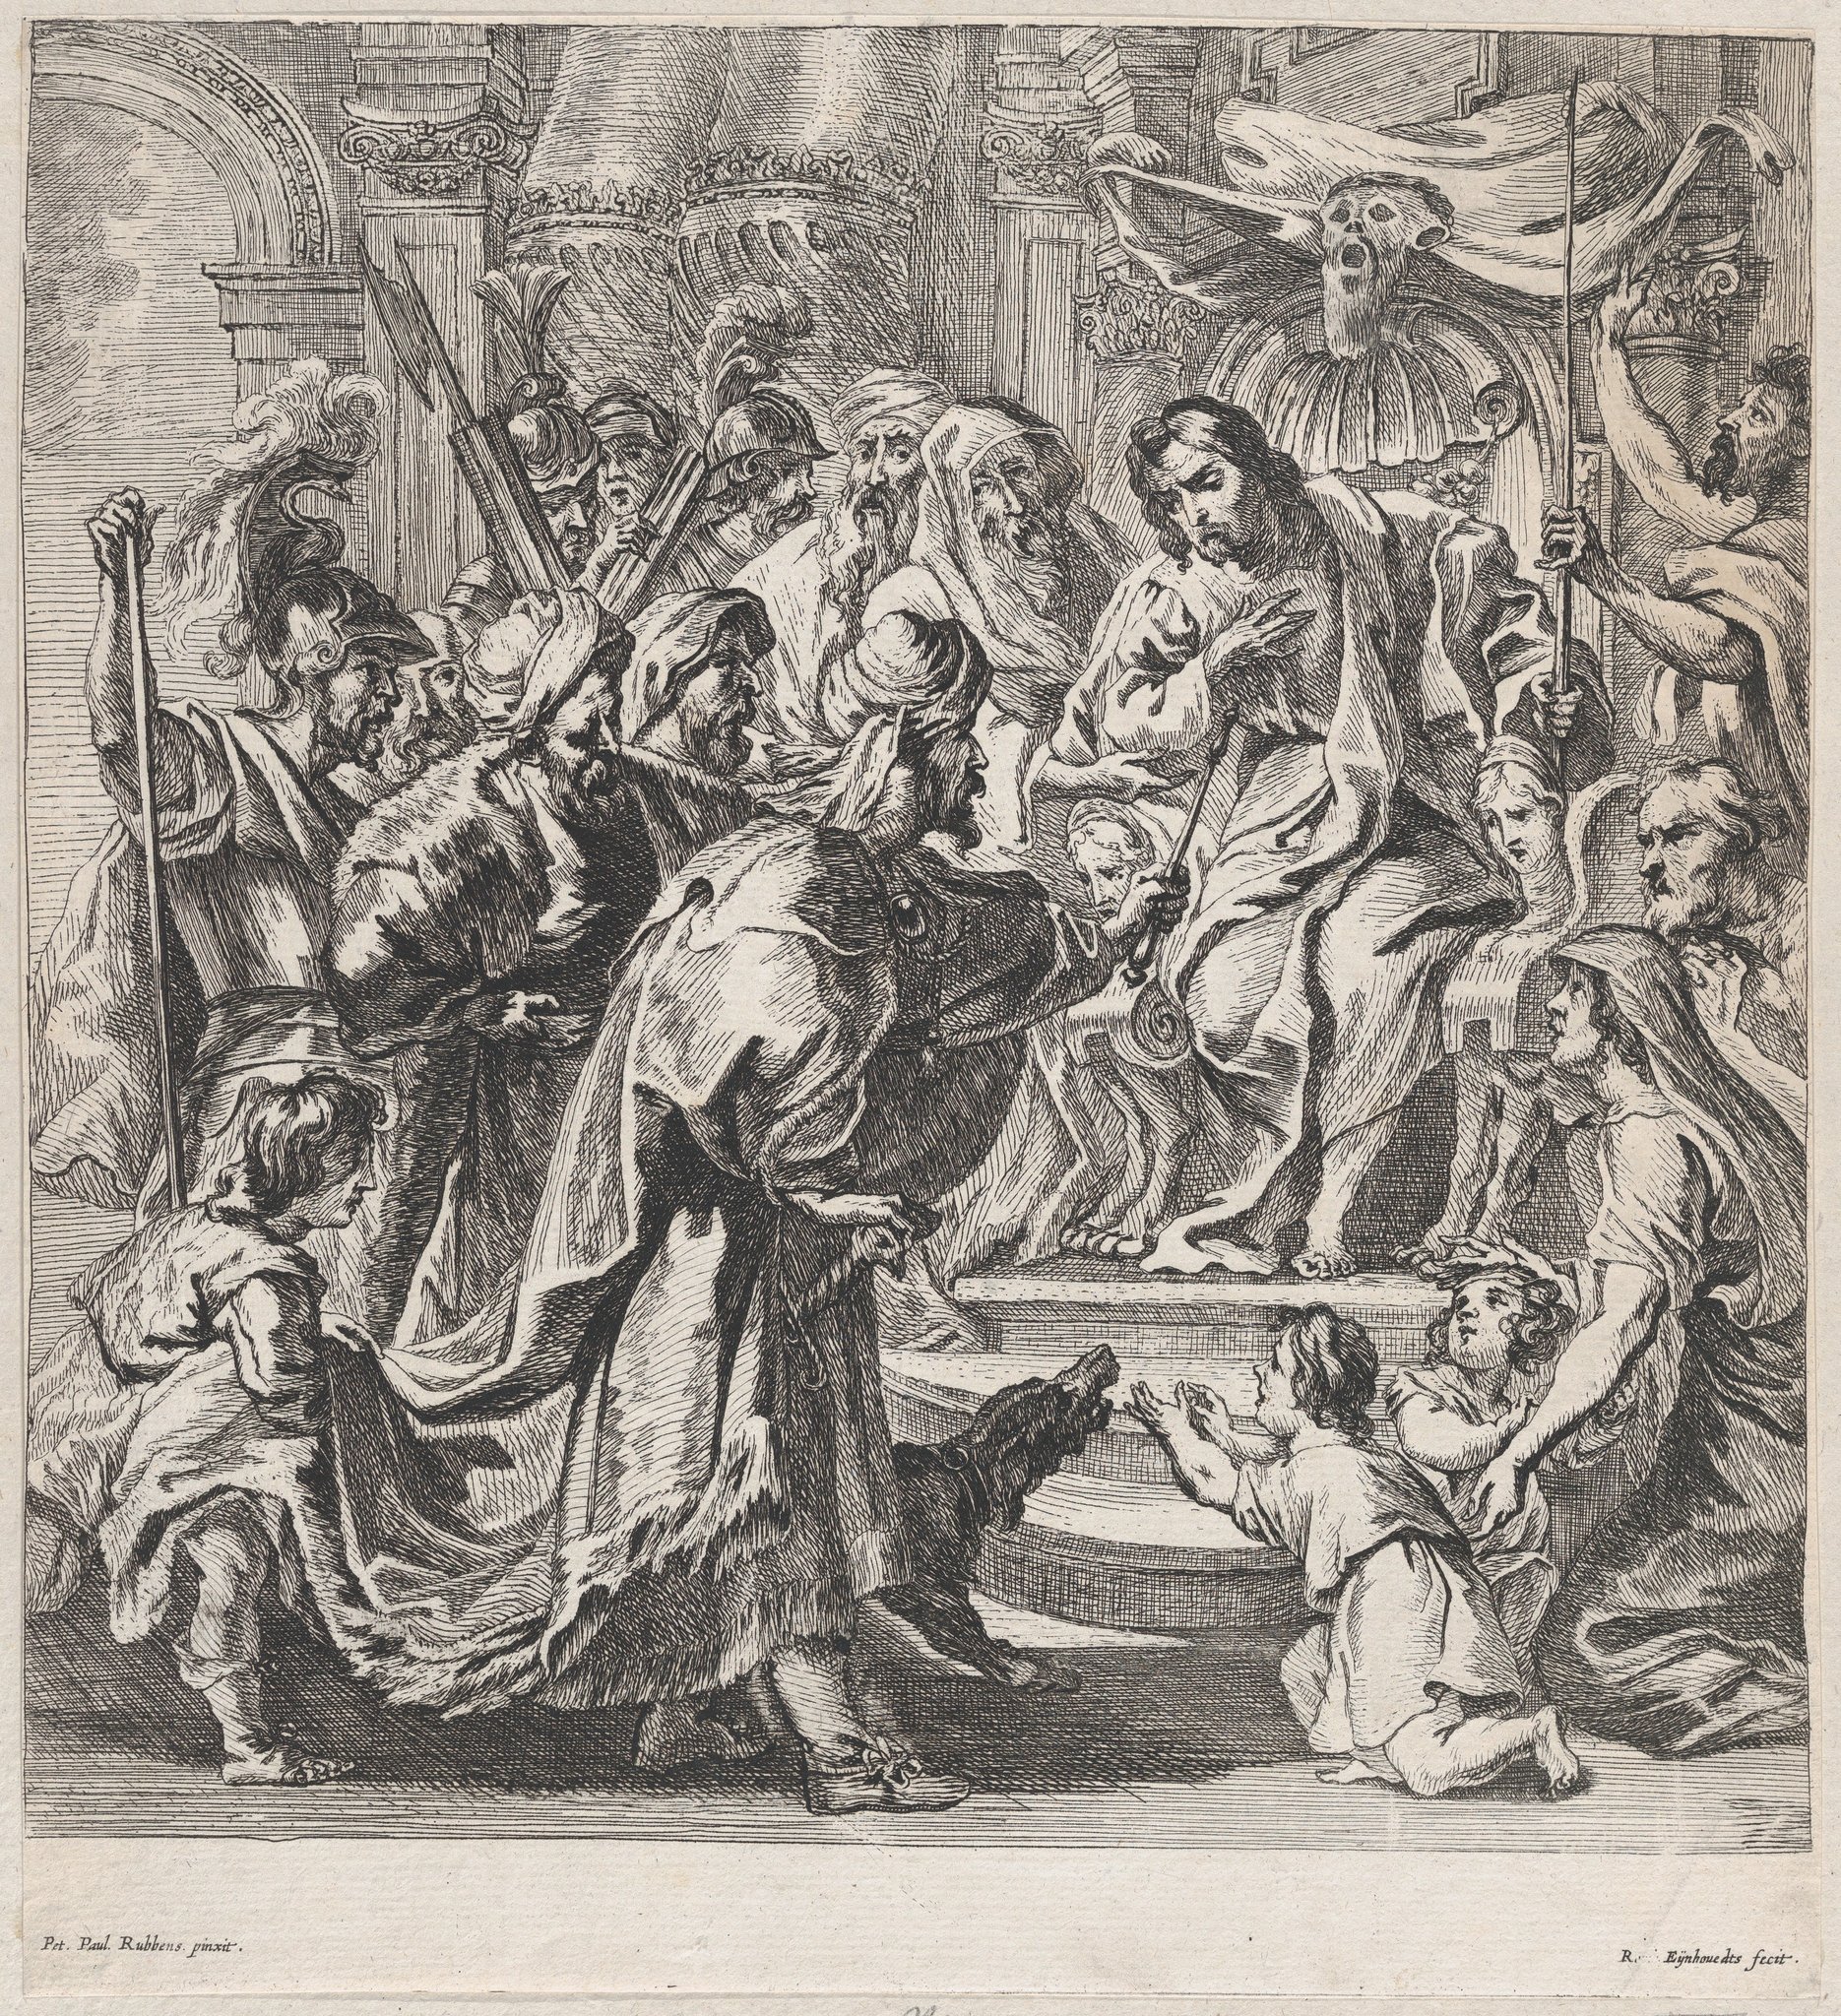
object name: print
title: Cambyses punishing the unjust judge Sisamnes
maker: rombout eynhoudts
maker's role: artist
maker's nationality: dutch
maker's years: 1613-1680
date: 1630-1680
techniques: etching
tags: children,men,women,dogs,punishment